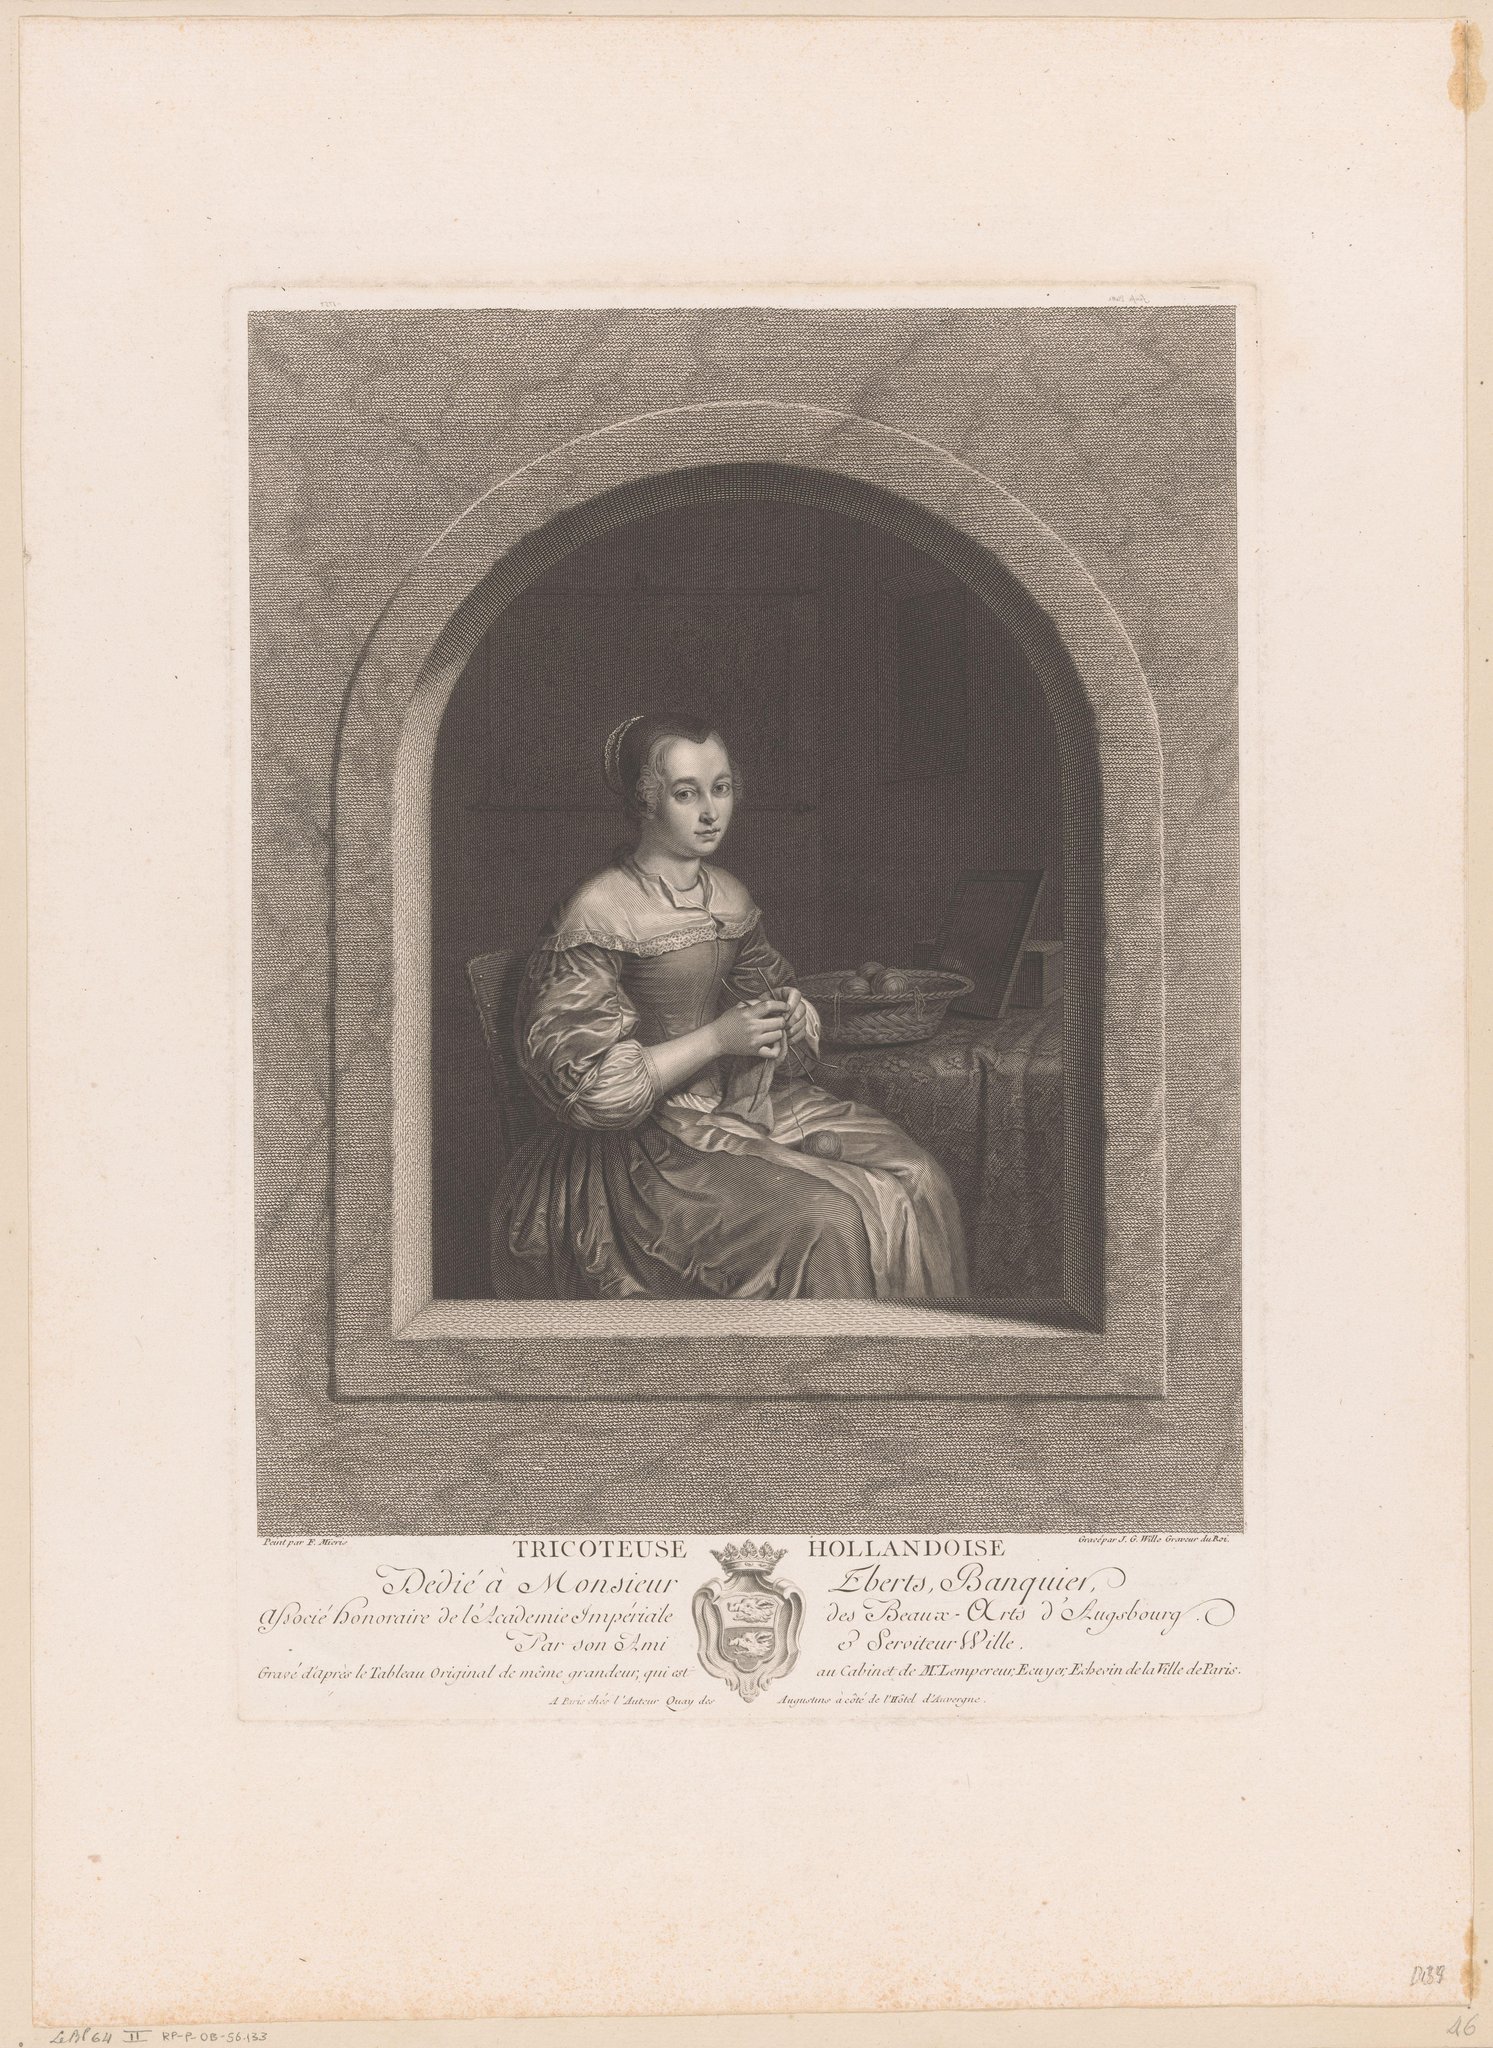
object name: print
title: Tricoteuse Hollandoise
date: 1757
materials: paper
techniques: engraving, etching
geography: paris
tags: adolescent, young woman, maiden, knitting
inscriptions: collector's mark: Lugt 240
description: Deze prent maakt deel uit van een serie van onbekende omvang naar Nederlandse en Duitse schilderijen. Op sommige prenten staat linksboven aangegeven welk nummer in de serie het betreft.